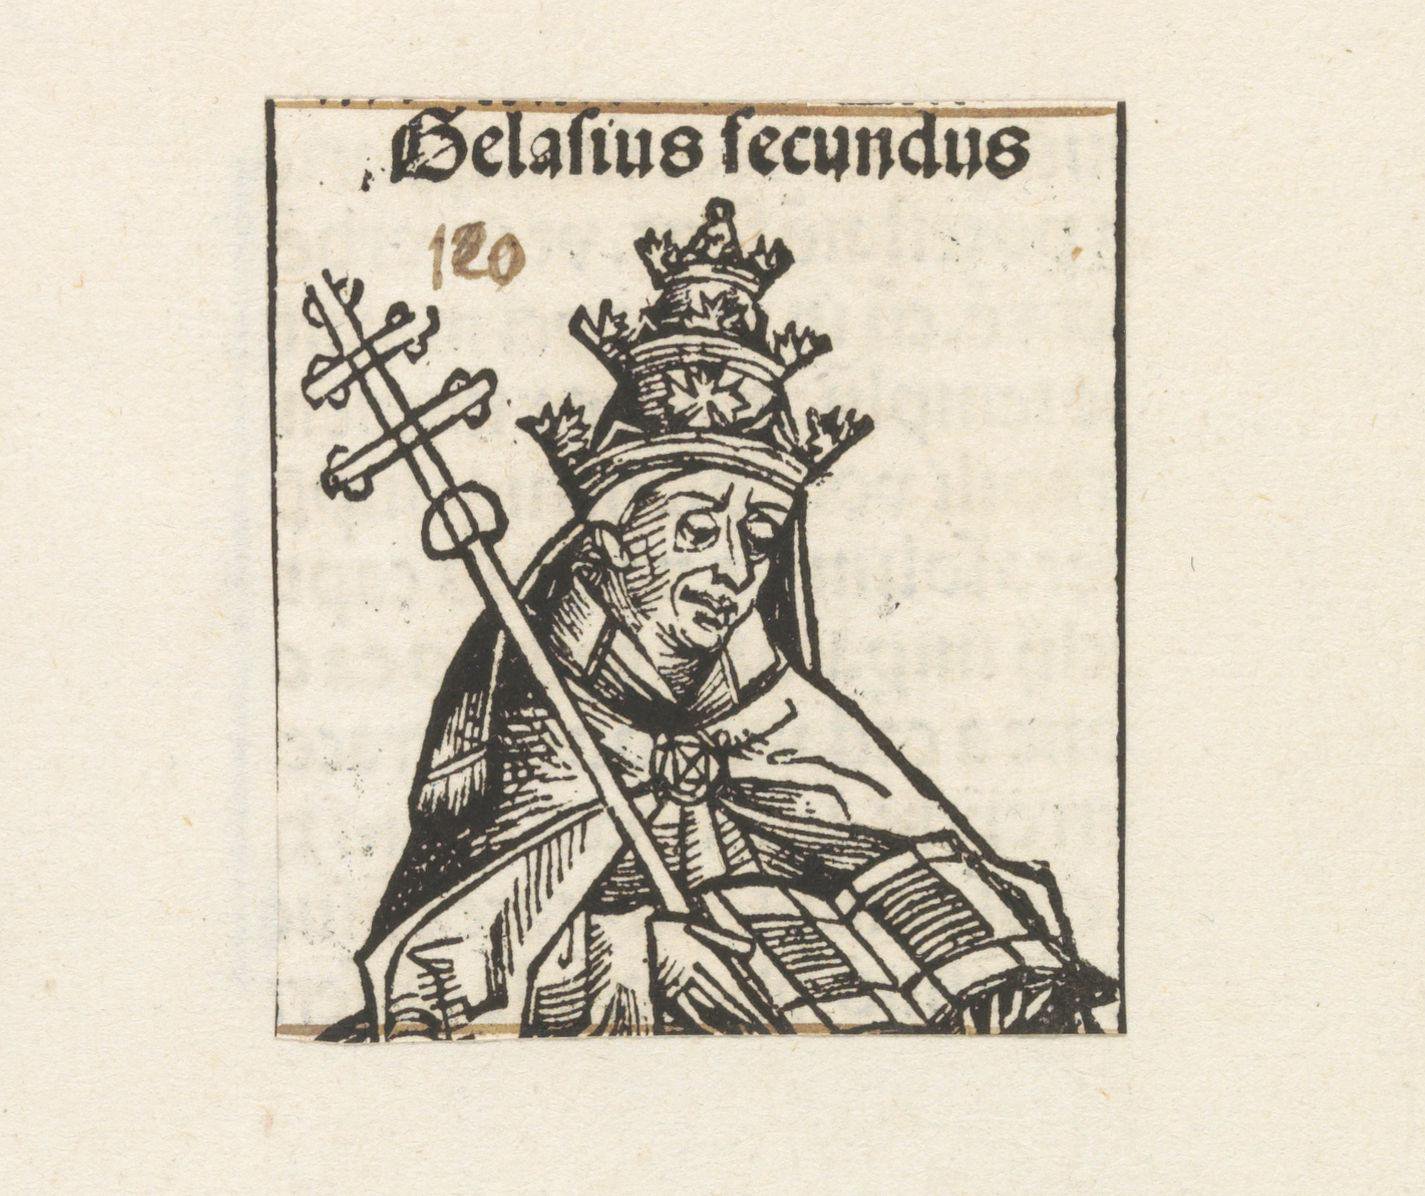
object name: album leaf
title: Paus Gelasius II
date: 1493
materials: paper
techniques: letterpress printing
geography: nuremberg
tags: pope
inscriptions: inscription: ‘120’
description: Een bloemkelk met een paus. Hij draagt een tiara en heeft een opengeslagen bijbel en een staf met een dubbel kruis in zijn handen. De voorstelling is onderdeel van de opeenvolging pausen in de Liber Chronicarum. De tekst identificeert de man als Gelasius II. De prent maakt deel uit van een album.